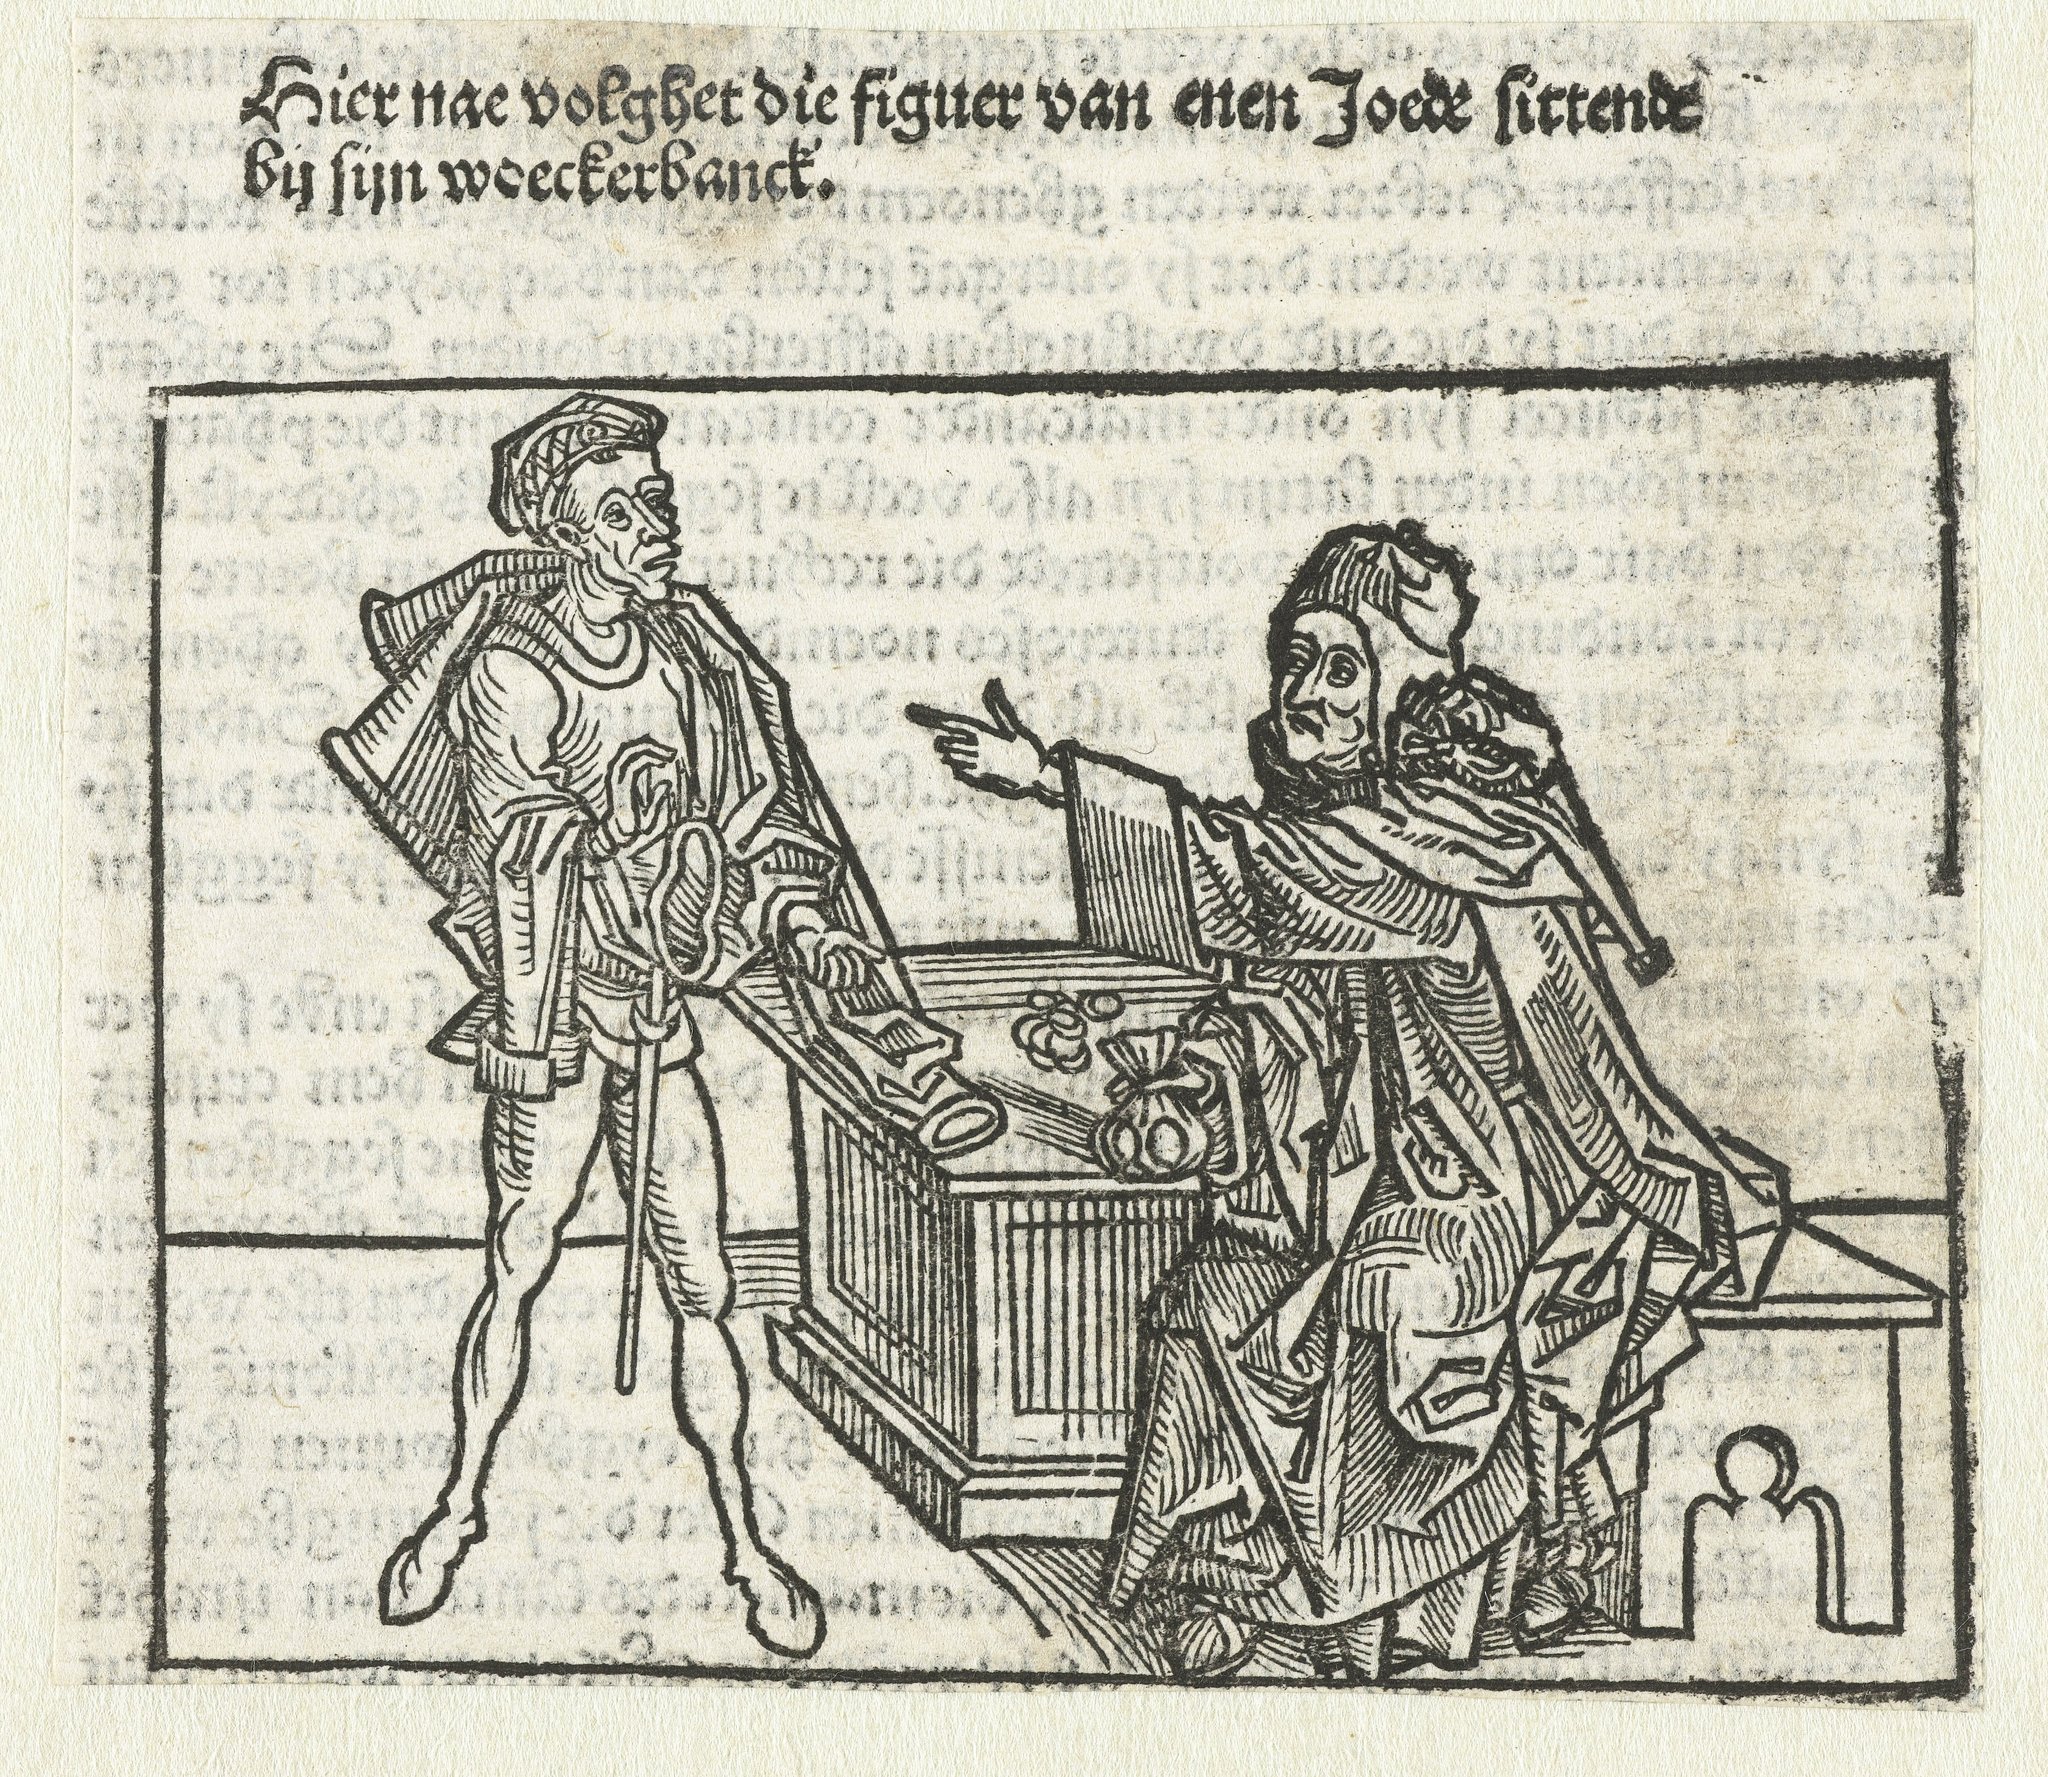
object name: book illustration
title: De joodse man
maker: erhard reuwich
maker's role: painter, print maker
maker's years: 1445-1505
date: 1486-1488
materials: paper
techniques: woodcut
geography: germany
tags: banker, the jews, jewish life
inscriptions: collector's mark: Lugt 2228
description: Illustratie voor het boek van Bernhard von Breidenbach, Reise ins Heilige Land. Een man in traditionele joodse kledij zittend bij een tafel, een geldbuidel in zijn rechterhand. Hij wijst naar de jongeman die voor hem staat. Boven de prent een tweeregelige tekst in het Nederlands.